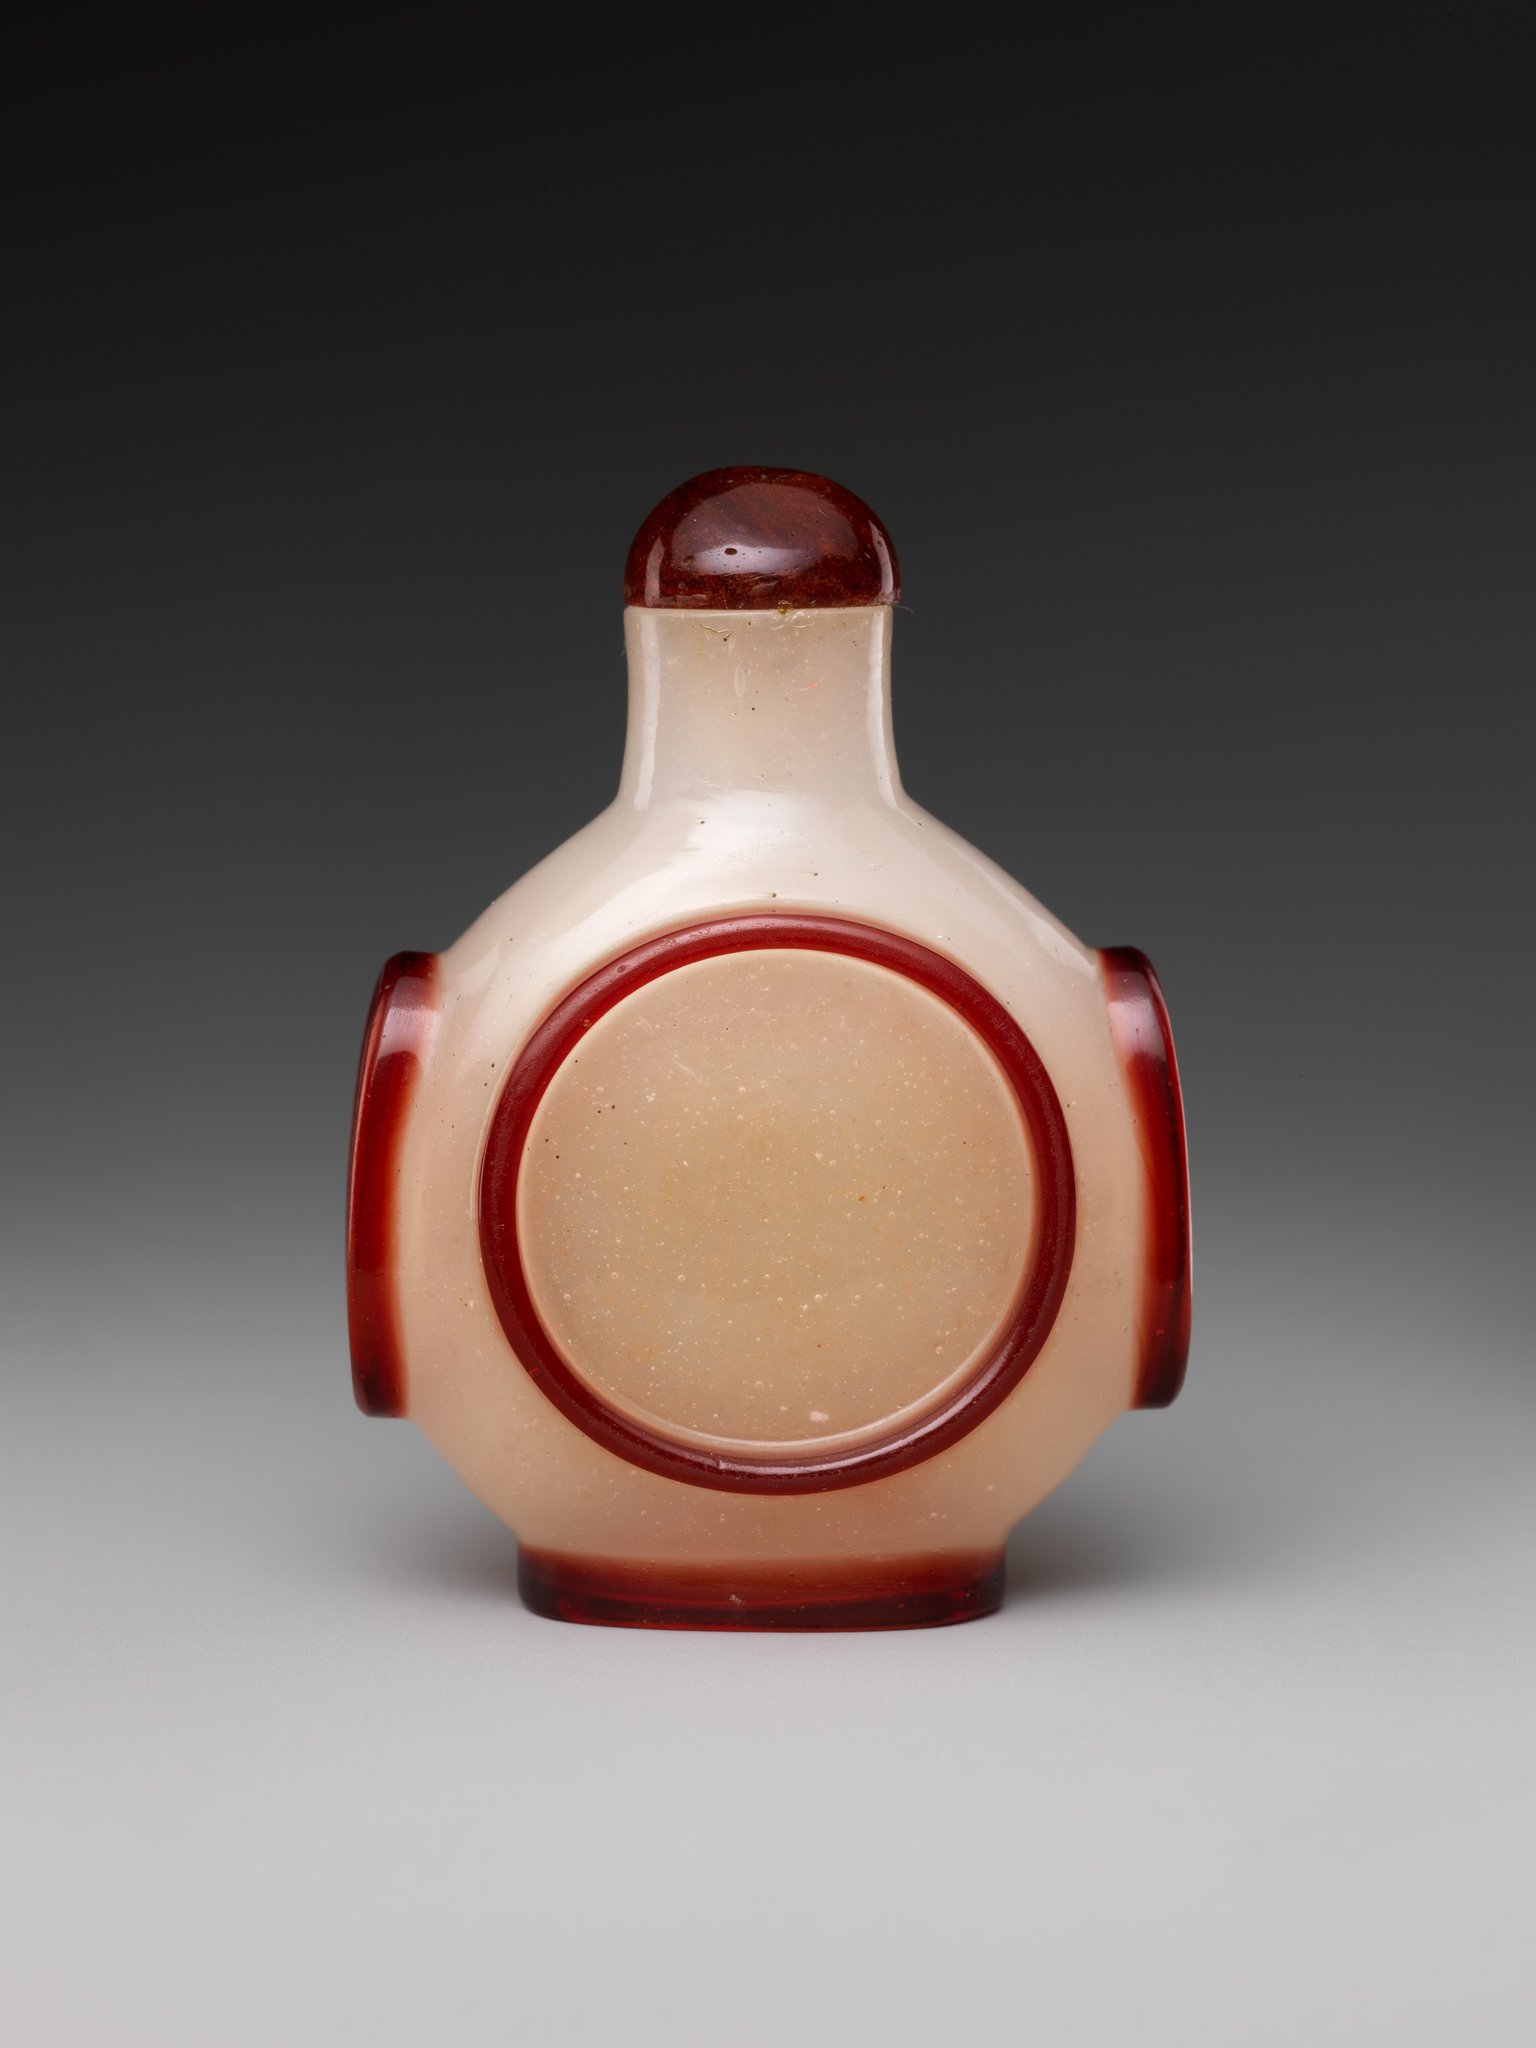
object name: snuff bottle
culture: chinese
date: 1701-1900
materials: glass